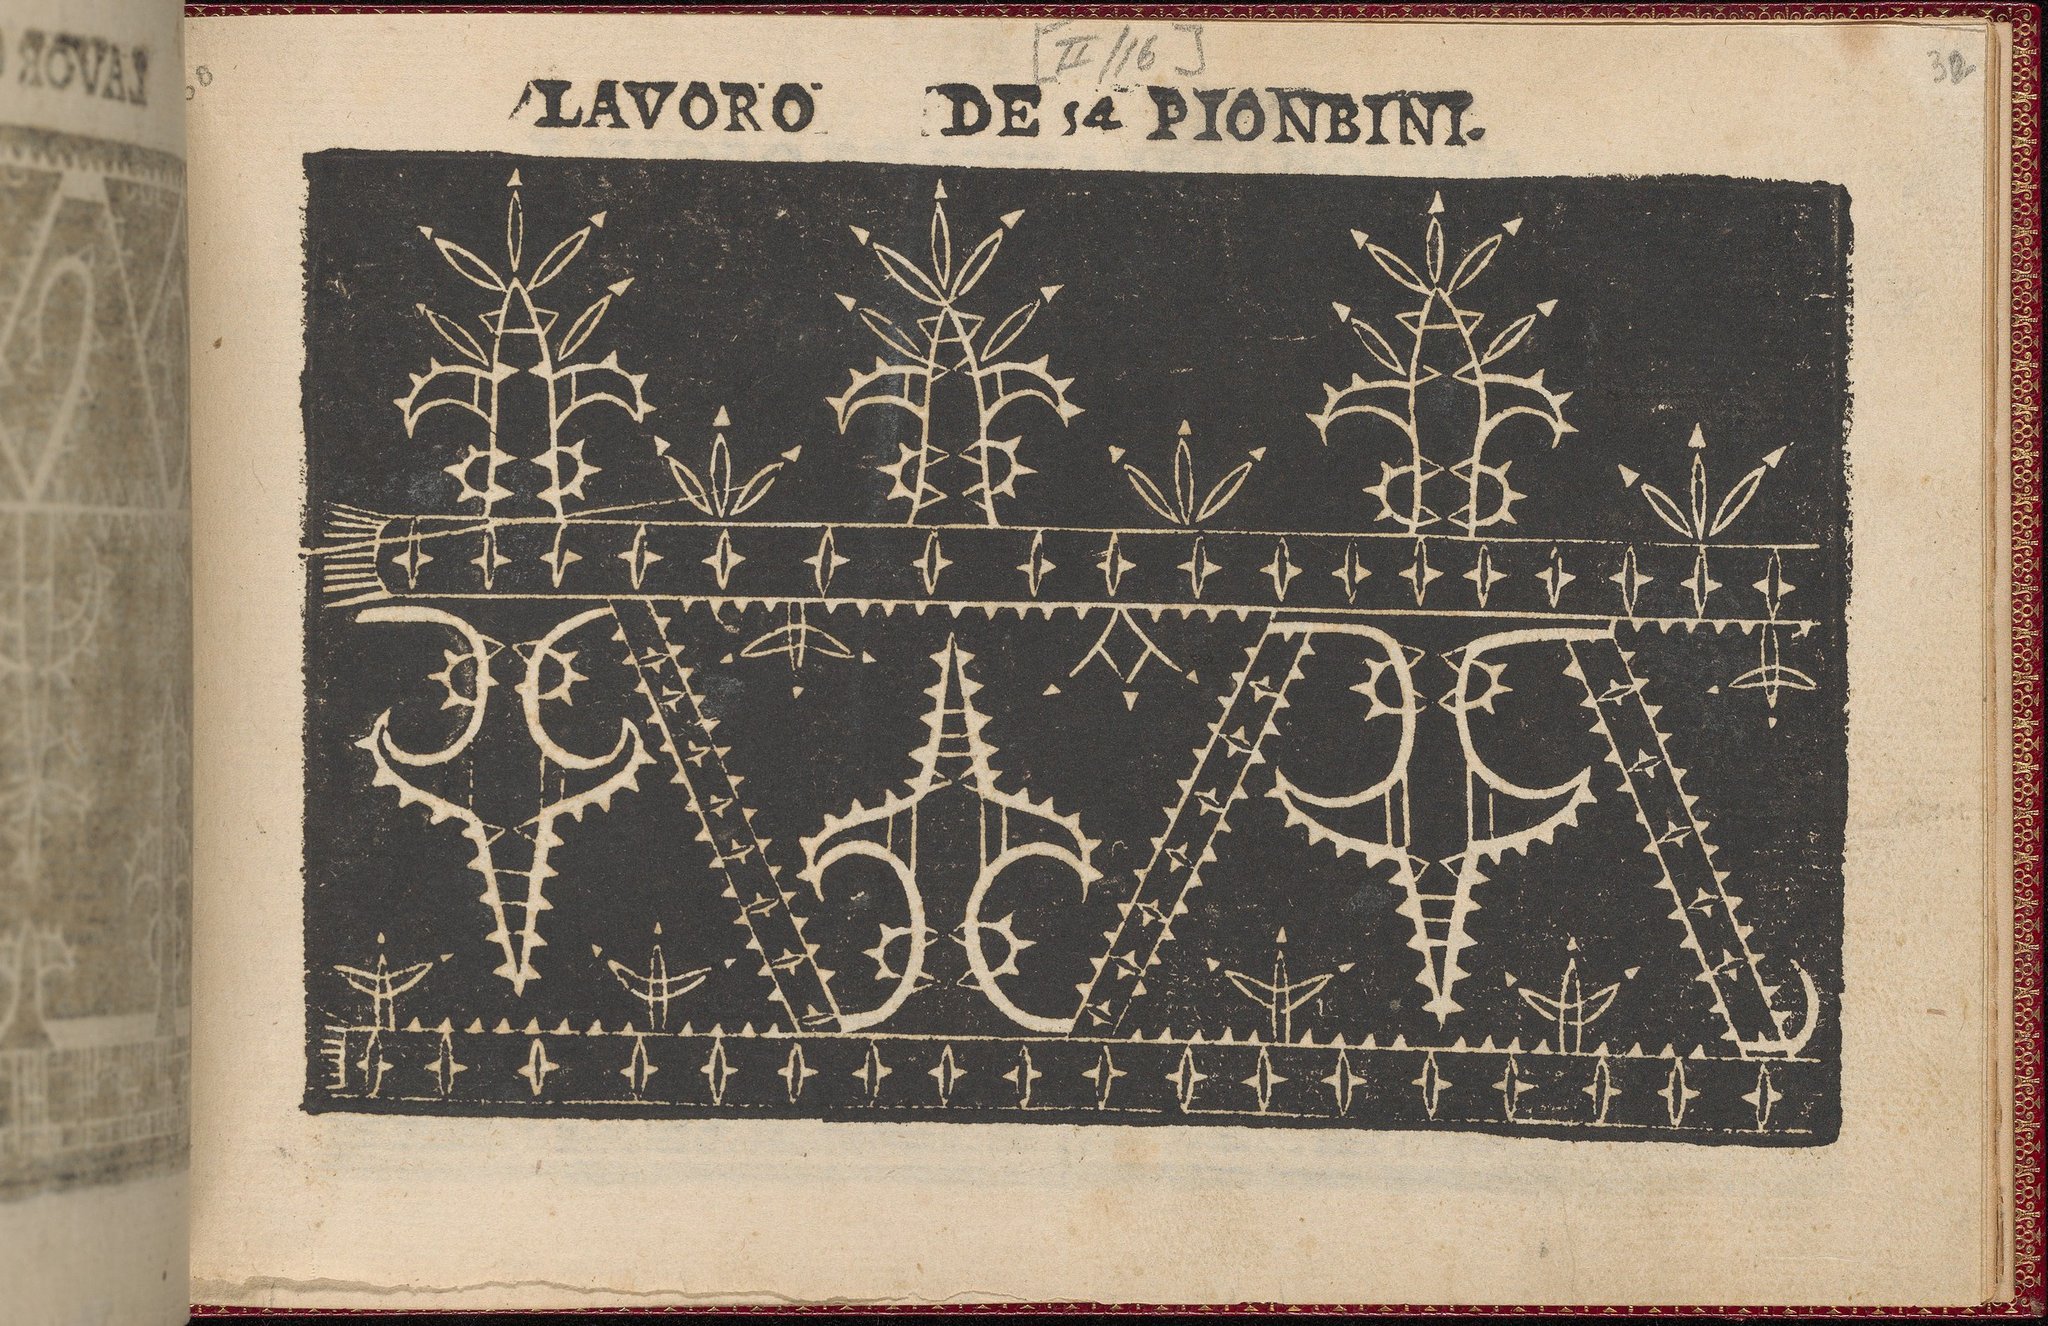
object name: book print ornament architecture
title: Pretiosa Gemma delle virtuose donne, page 34 (recto)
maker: isabella catanea parasole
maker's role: author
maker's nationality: italian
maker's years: 1565-1625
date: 1600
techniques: woodcut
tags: ornament